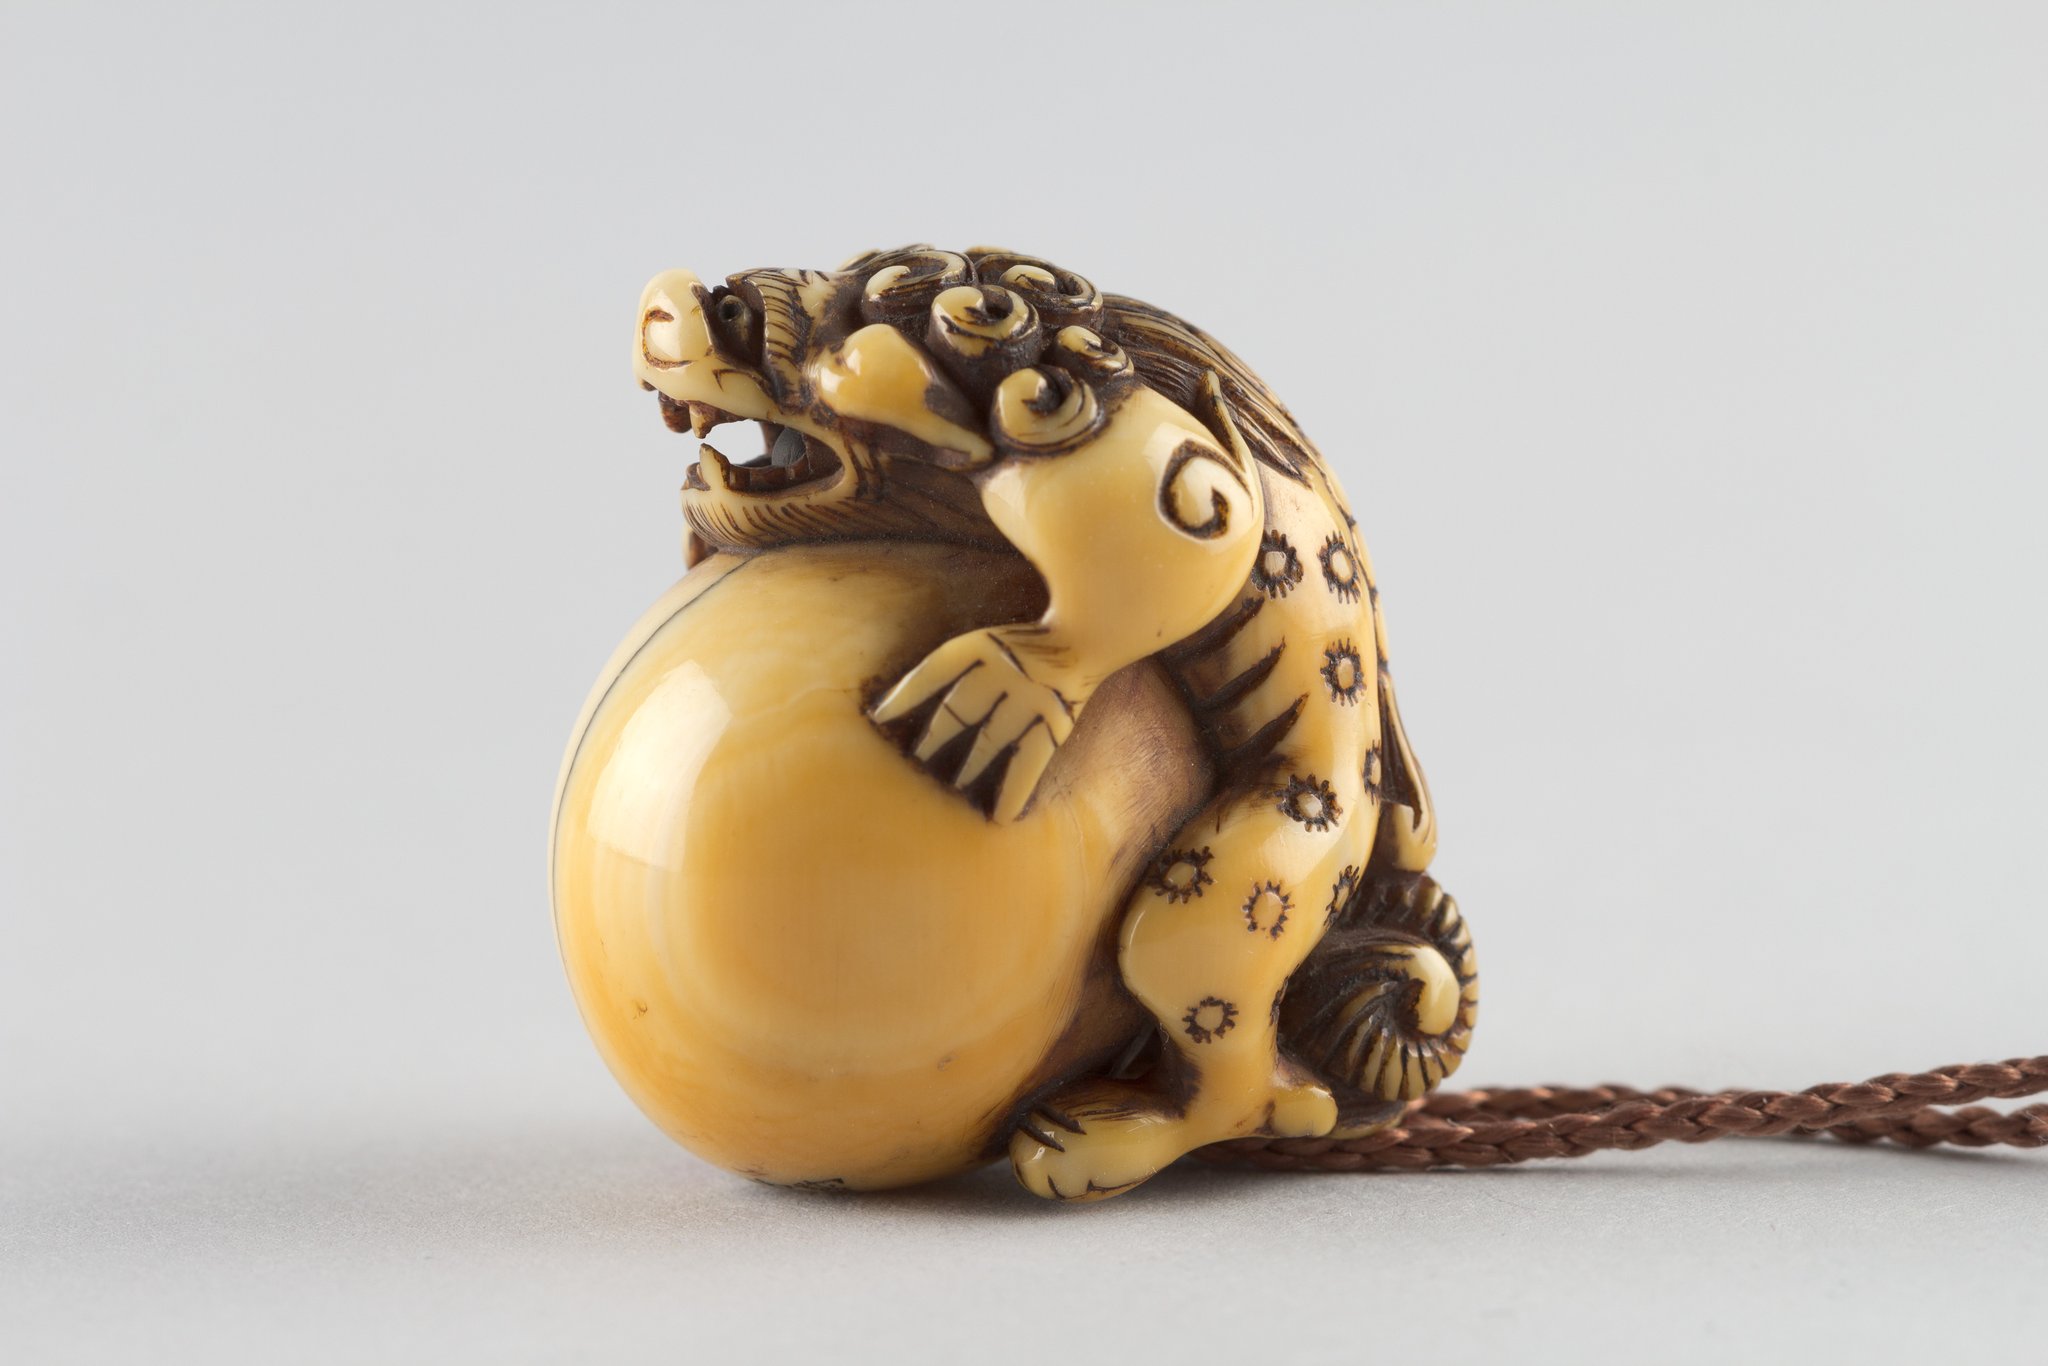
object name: netsuke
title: Netsuke in the Shape of a Lion with a Ball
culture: japanese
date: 1801-1900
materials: ivory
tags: lions